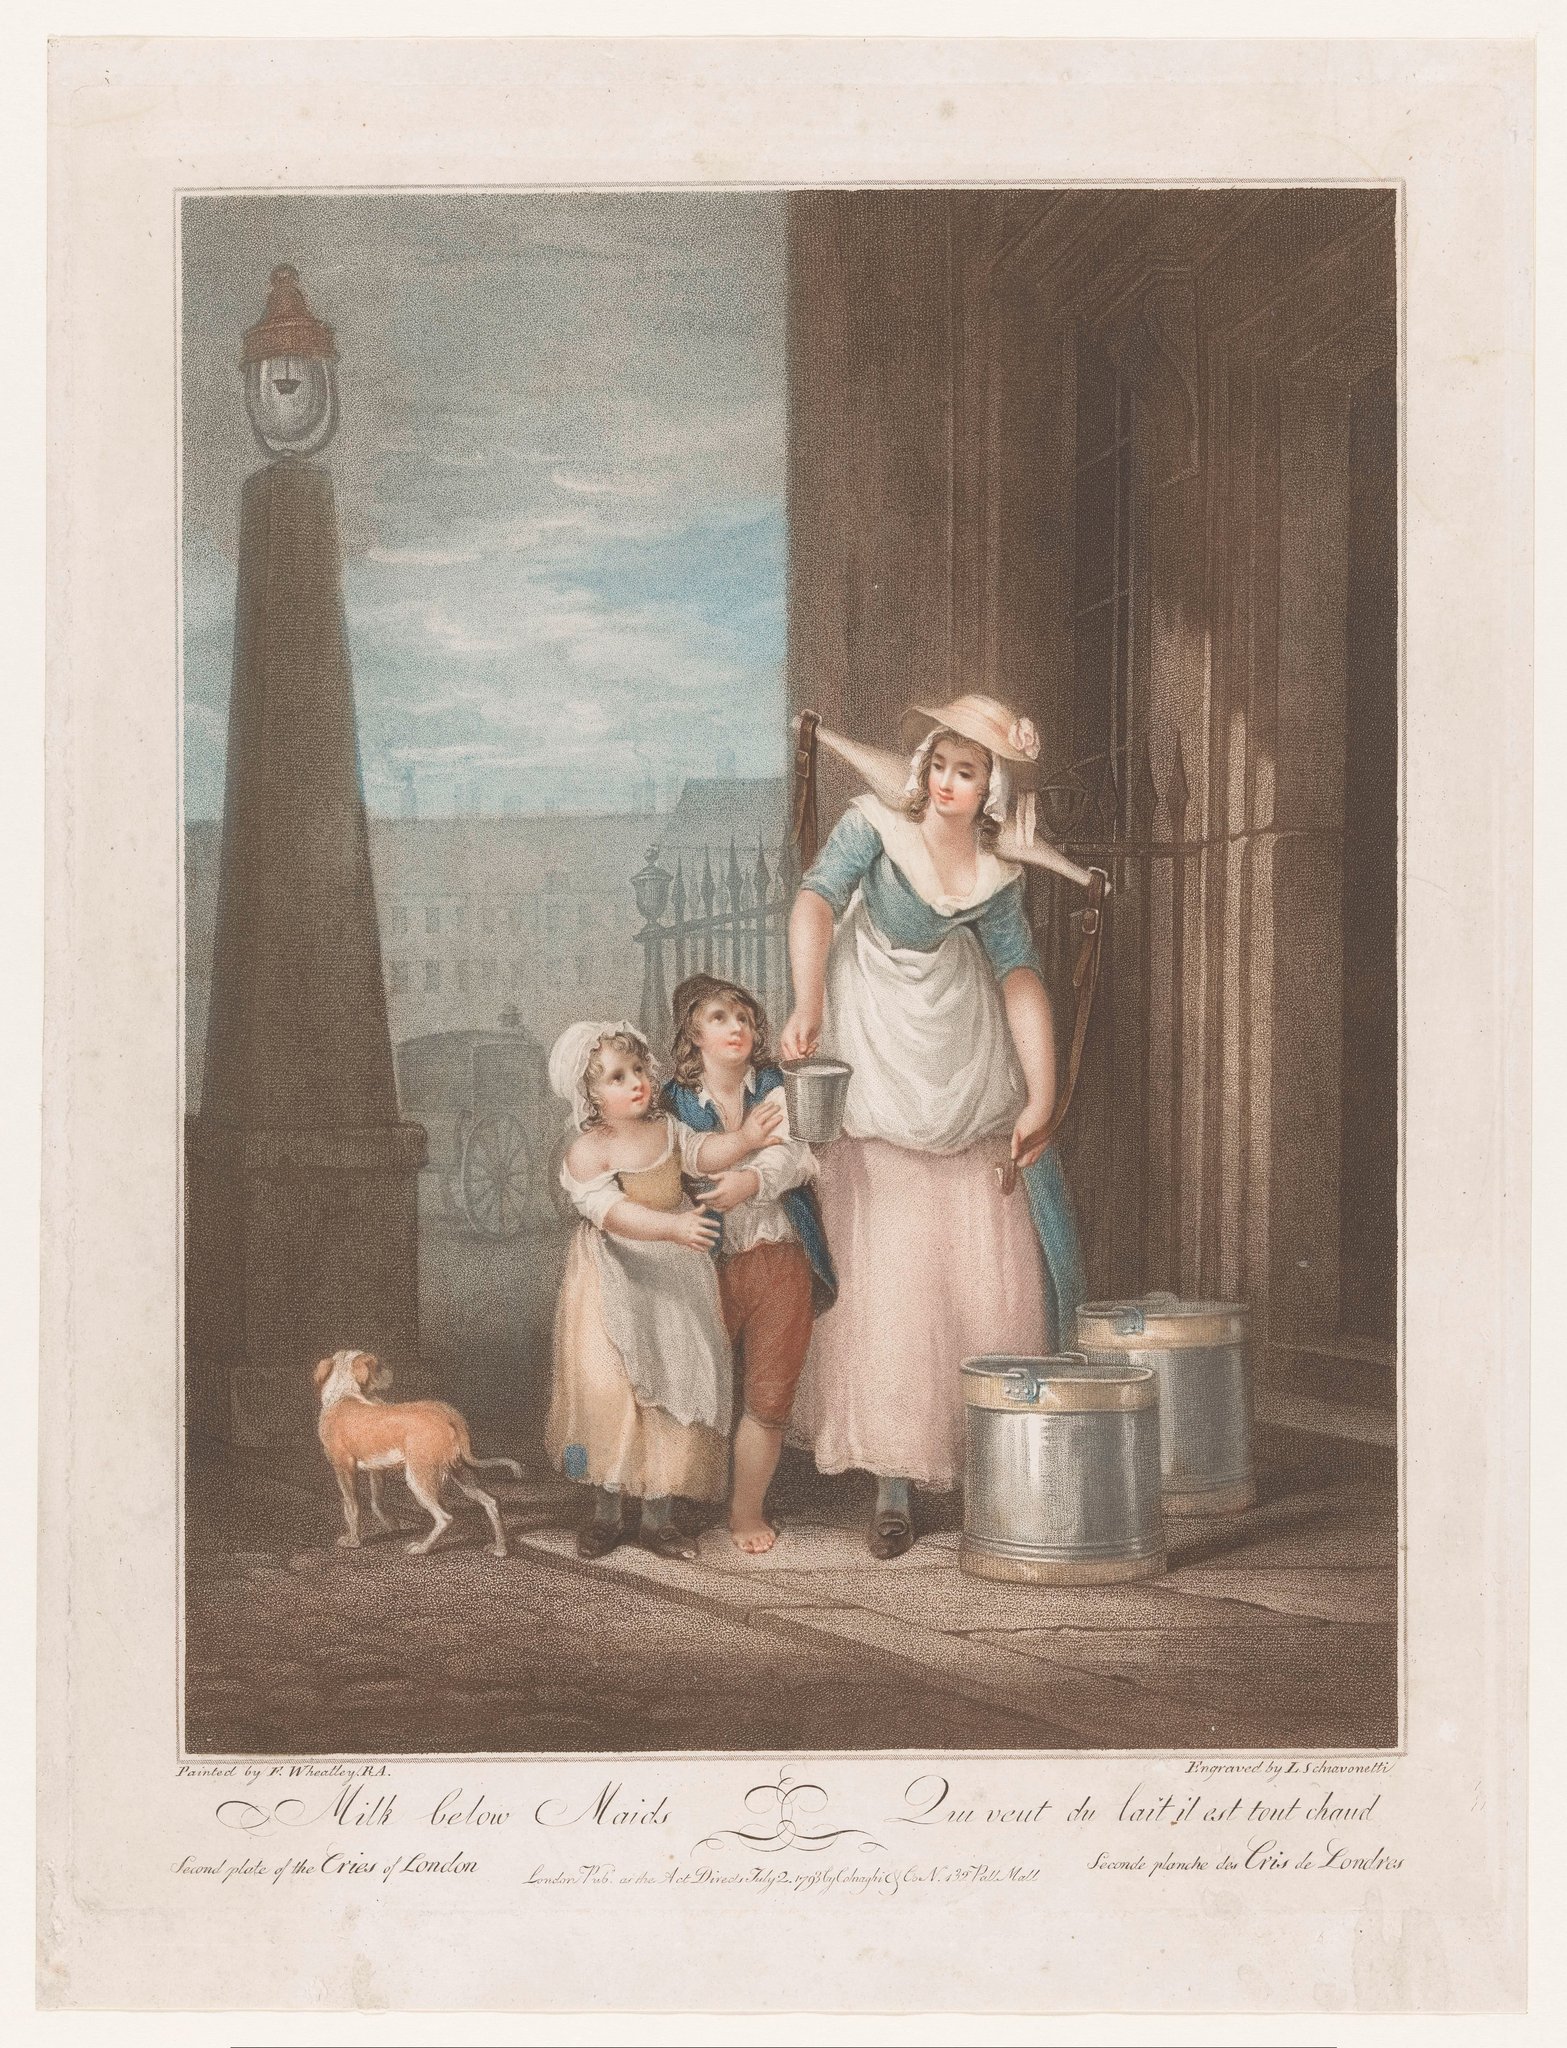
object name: print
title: Cries of London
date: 1793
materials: paper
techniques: printing, colour, engraving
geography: london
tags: carrying something with yoke, milkmaid, selling, 'cris de paris', cries of london, etc.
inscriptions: collector's mark: Lugt 2228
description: Een jonge vrouw met een juk op haar schouders, staand op straat in gezelschap van twee jonge kinderen. Naast haar twee grote melkemmers en in haar rechterhand een kleinere emmer. Links een hond en een straatlantaarn. Titel in ondermarge.